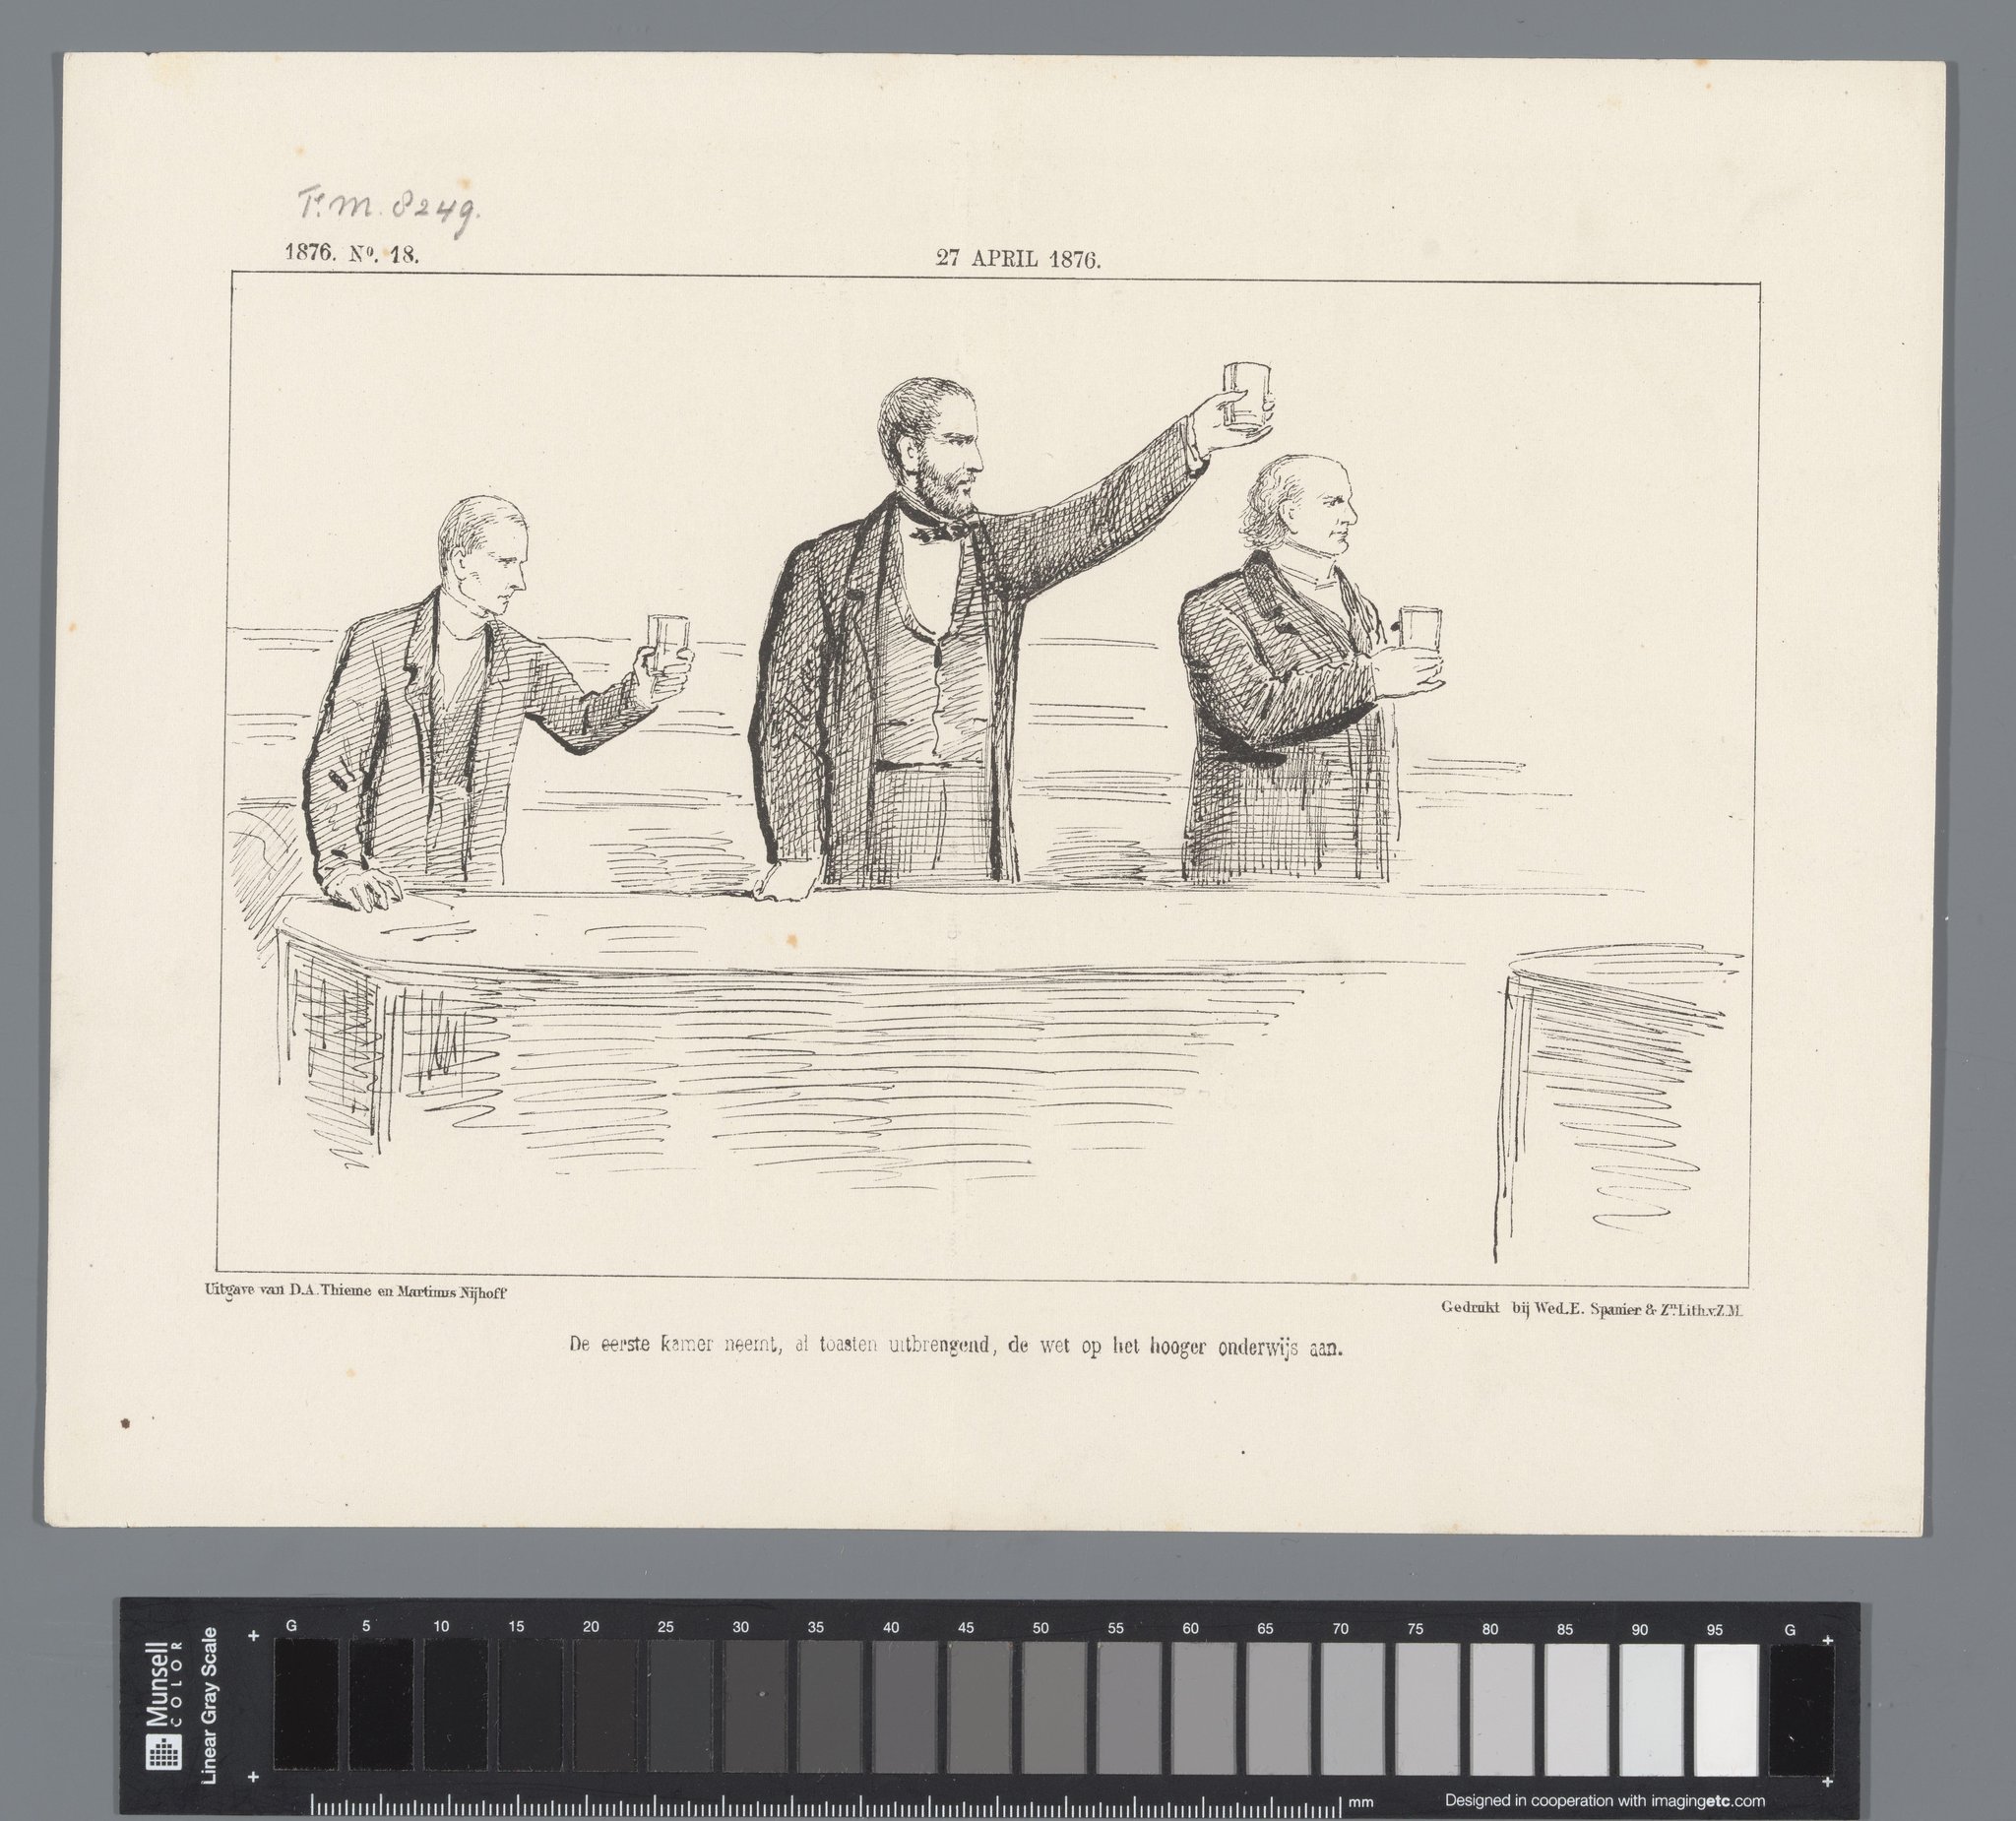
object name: cartoon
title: Spotprent op Mozes Salvador, 1853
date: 1853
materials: paper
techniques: tone lithography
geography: netherlands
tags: politician, political meeting, propaganda meeting, utrecht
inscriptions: collector's mark: Lugt 2228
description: Spotprent op Mozes Salvador en de door hem georganiseerde politieke bijeenkomst te Utrecht bij de verkiezingen voor de Tweede Kamer, 17 mei 1853. Twee voorstellingen: Vóór en Ná. Links (vóór) spreekt Salvador met zijn zaakwaarnemer S. Fongers een zaal toe, allen voorgesteld als vissen. Rechts (ná) eindigt Salvador in een vispastei op de kruiwagen van een visverkoper.